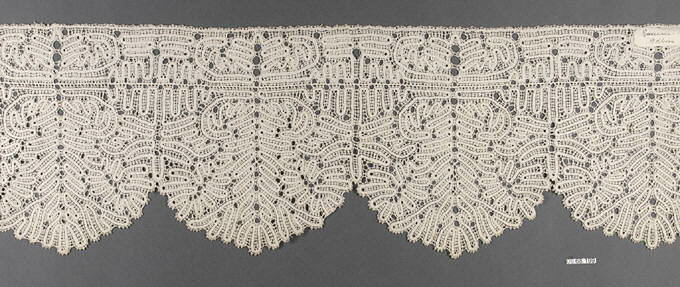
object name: strip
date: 1801-1900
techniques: lace